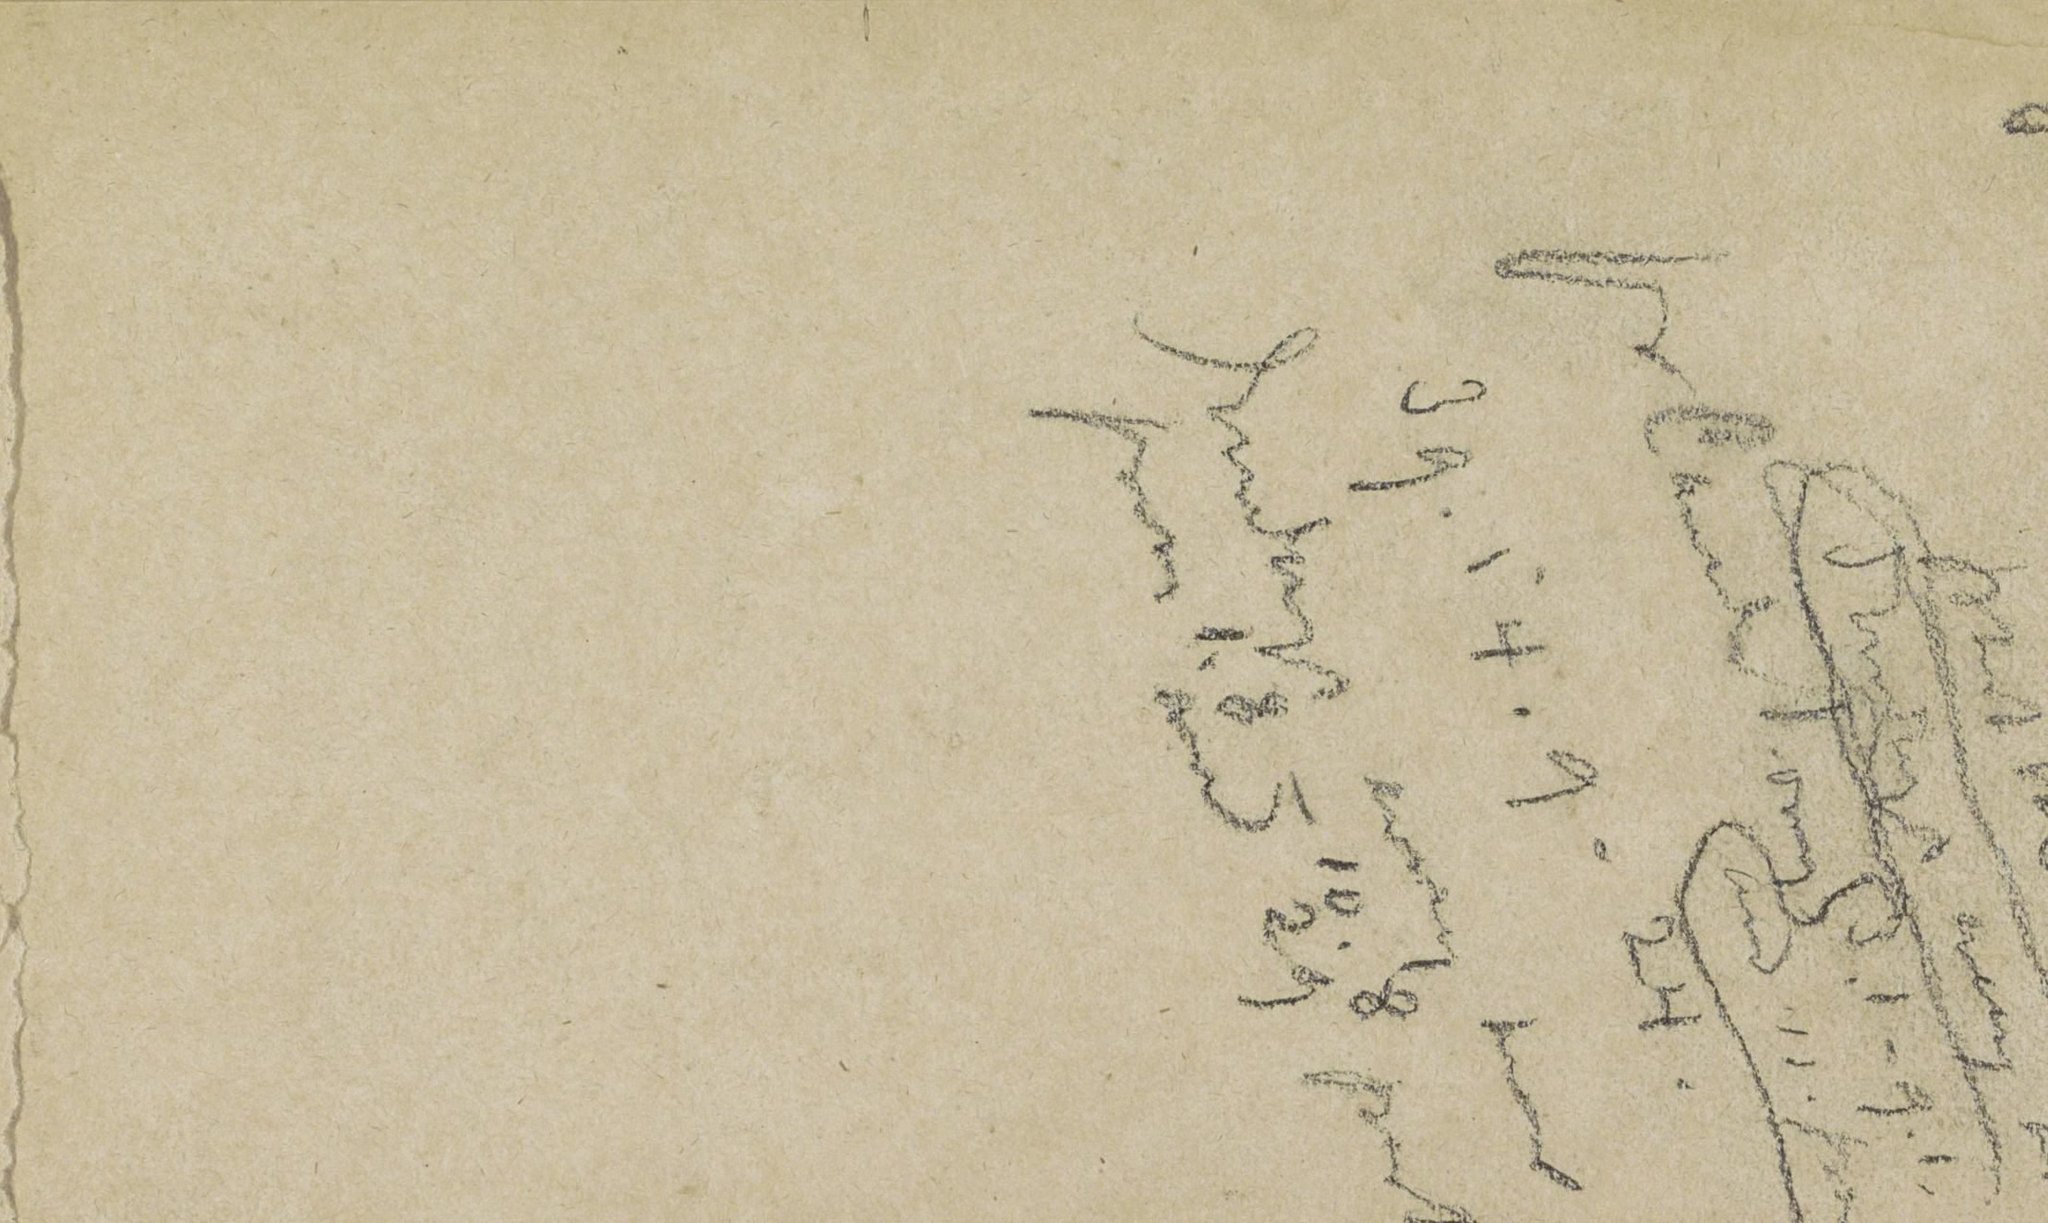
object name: sketchbook leaf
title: Annotaties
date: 1888-1891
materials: chalk, paper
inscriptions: annotation: ‘[...]’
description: Pagina 1 uit een schetsboek met 27 bladen.